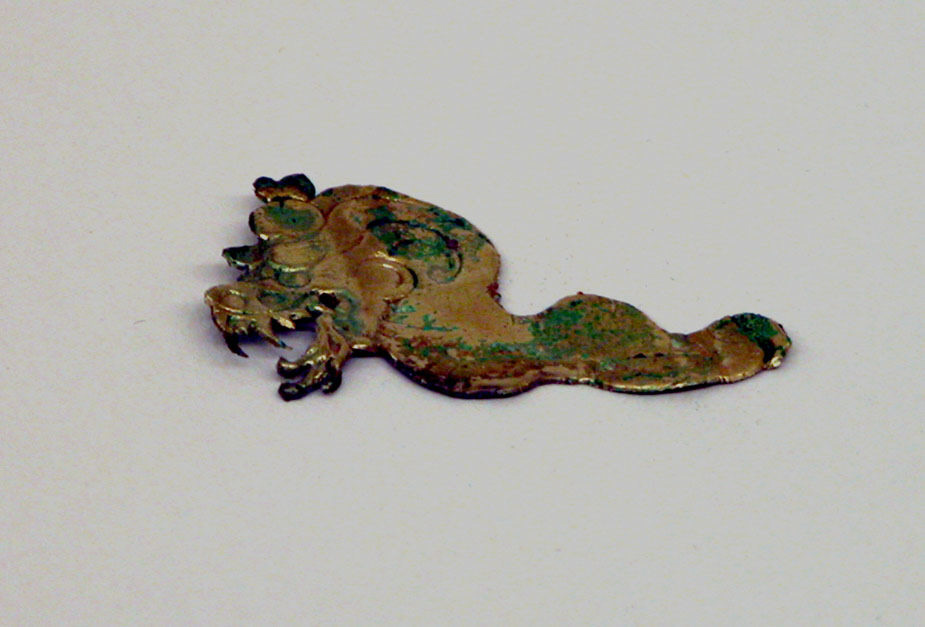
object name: funerary object pripihs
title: Ten Pripih (Funerary objects) Depicting Various Animals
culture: indonesian, javanese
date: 1001-1300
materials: gold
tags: animals,birds